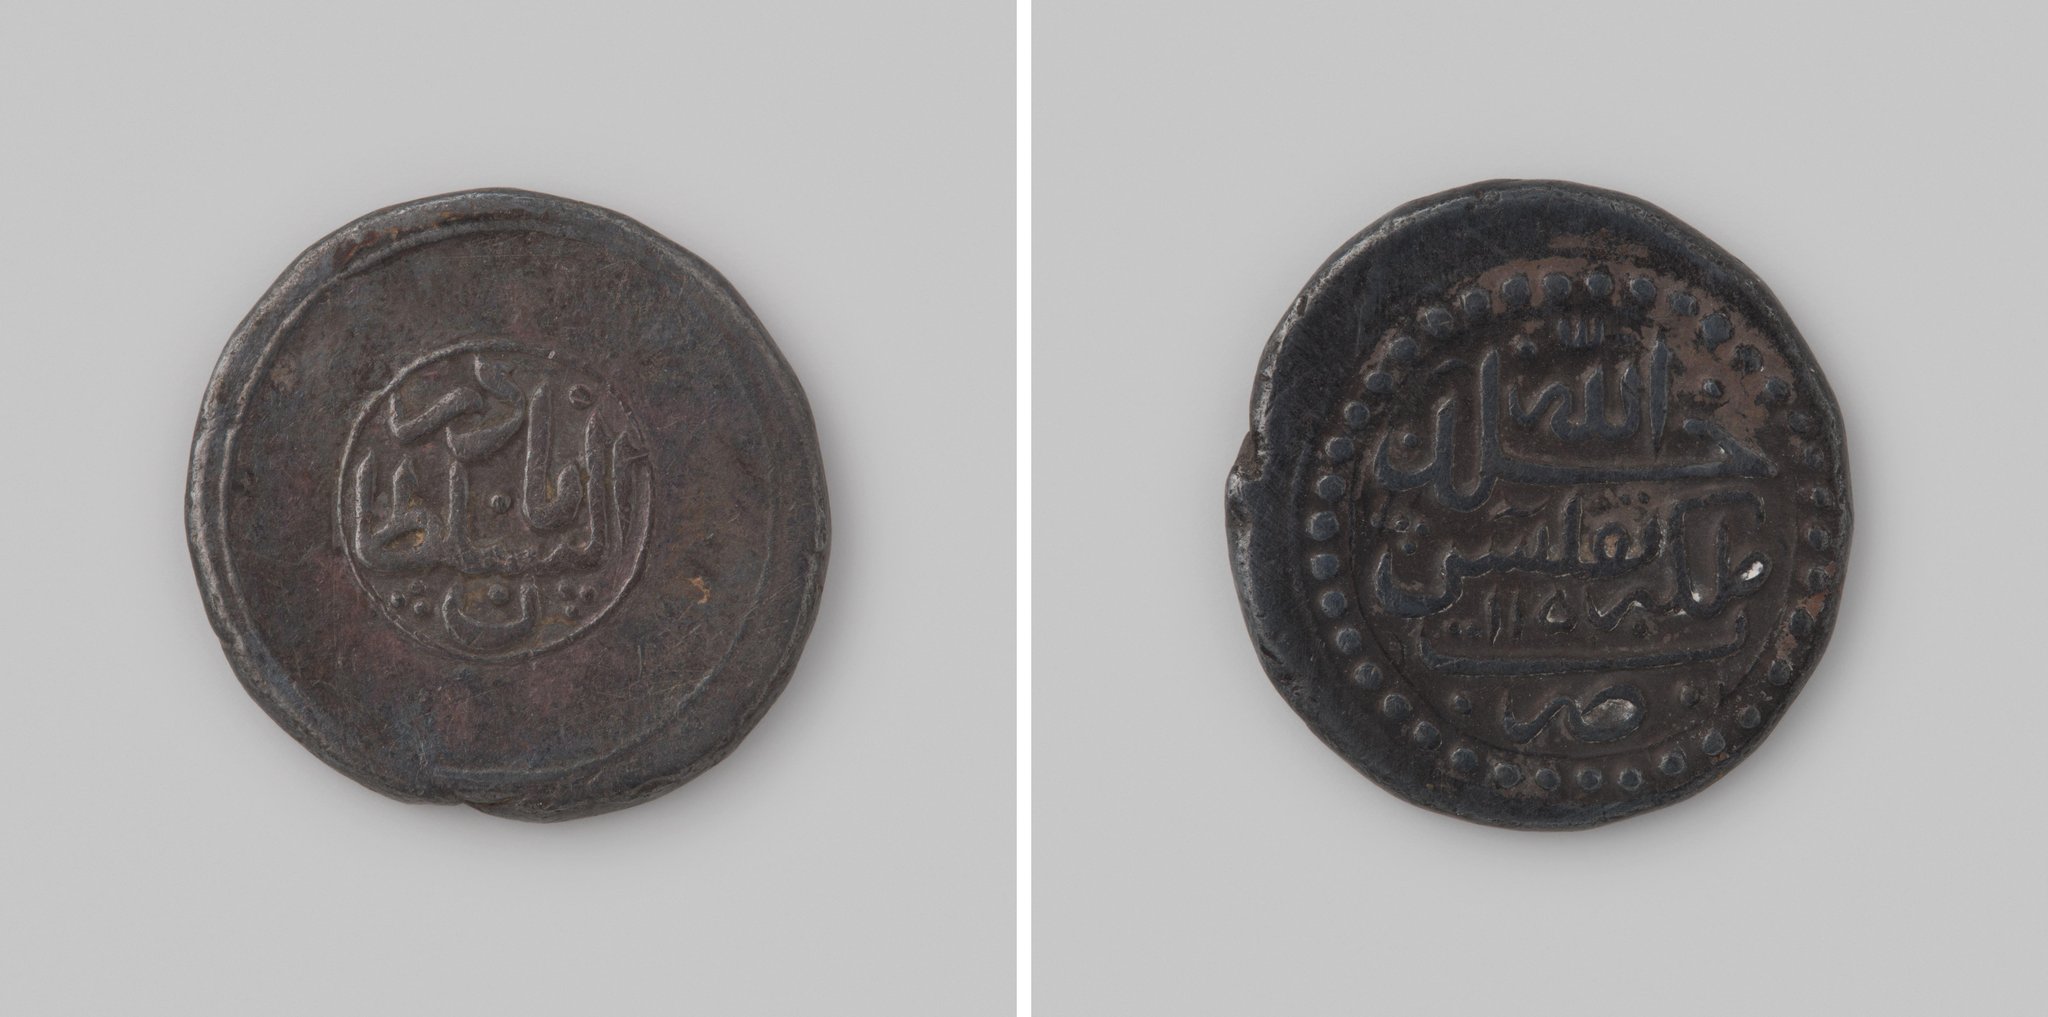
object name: coin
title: Perzië, sjah Nadir, 1148-1160 AH [=1735-1747], 6 shani,1150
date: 1739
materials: silver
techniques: striking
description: Zilveren munt. Voorzijde: binnen cirkel in drie regels opschrift: aanduiding van de sjah als sultan. Rondom cirkel brede, gladde rand. Keerzijde: in Arabische lettertekens in twee regels rijmdicht. In linker gedeelte van tweede regel muntplaats-aanduiding: Tiflis, waaronder jaartal. Gladde rand.